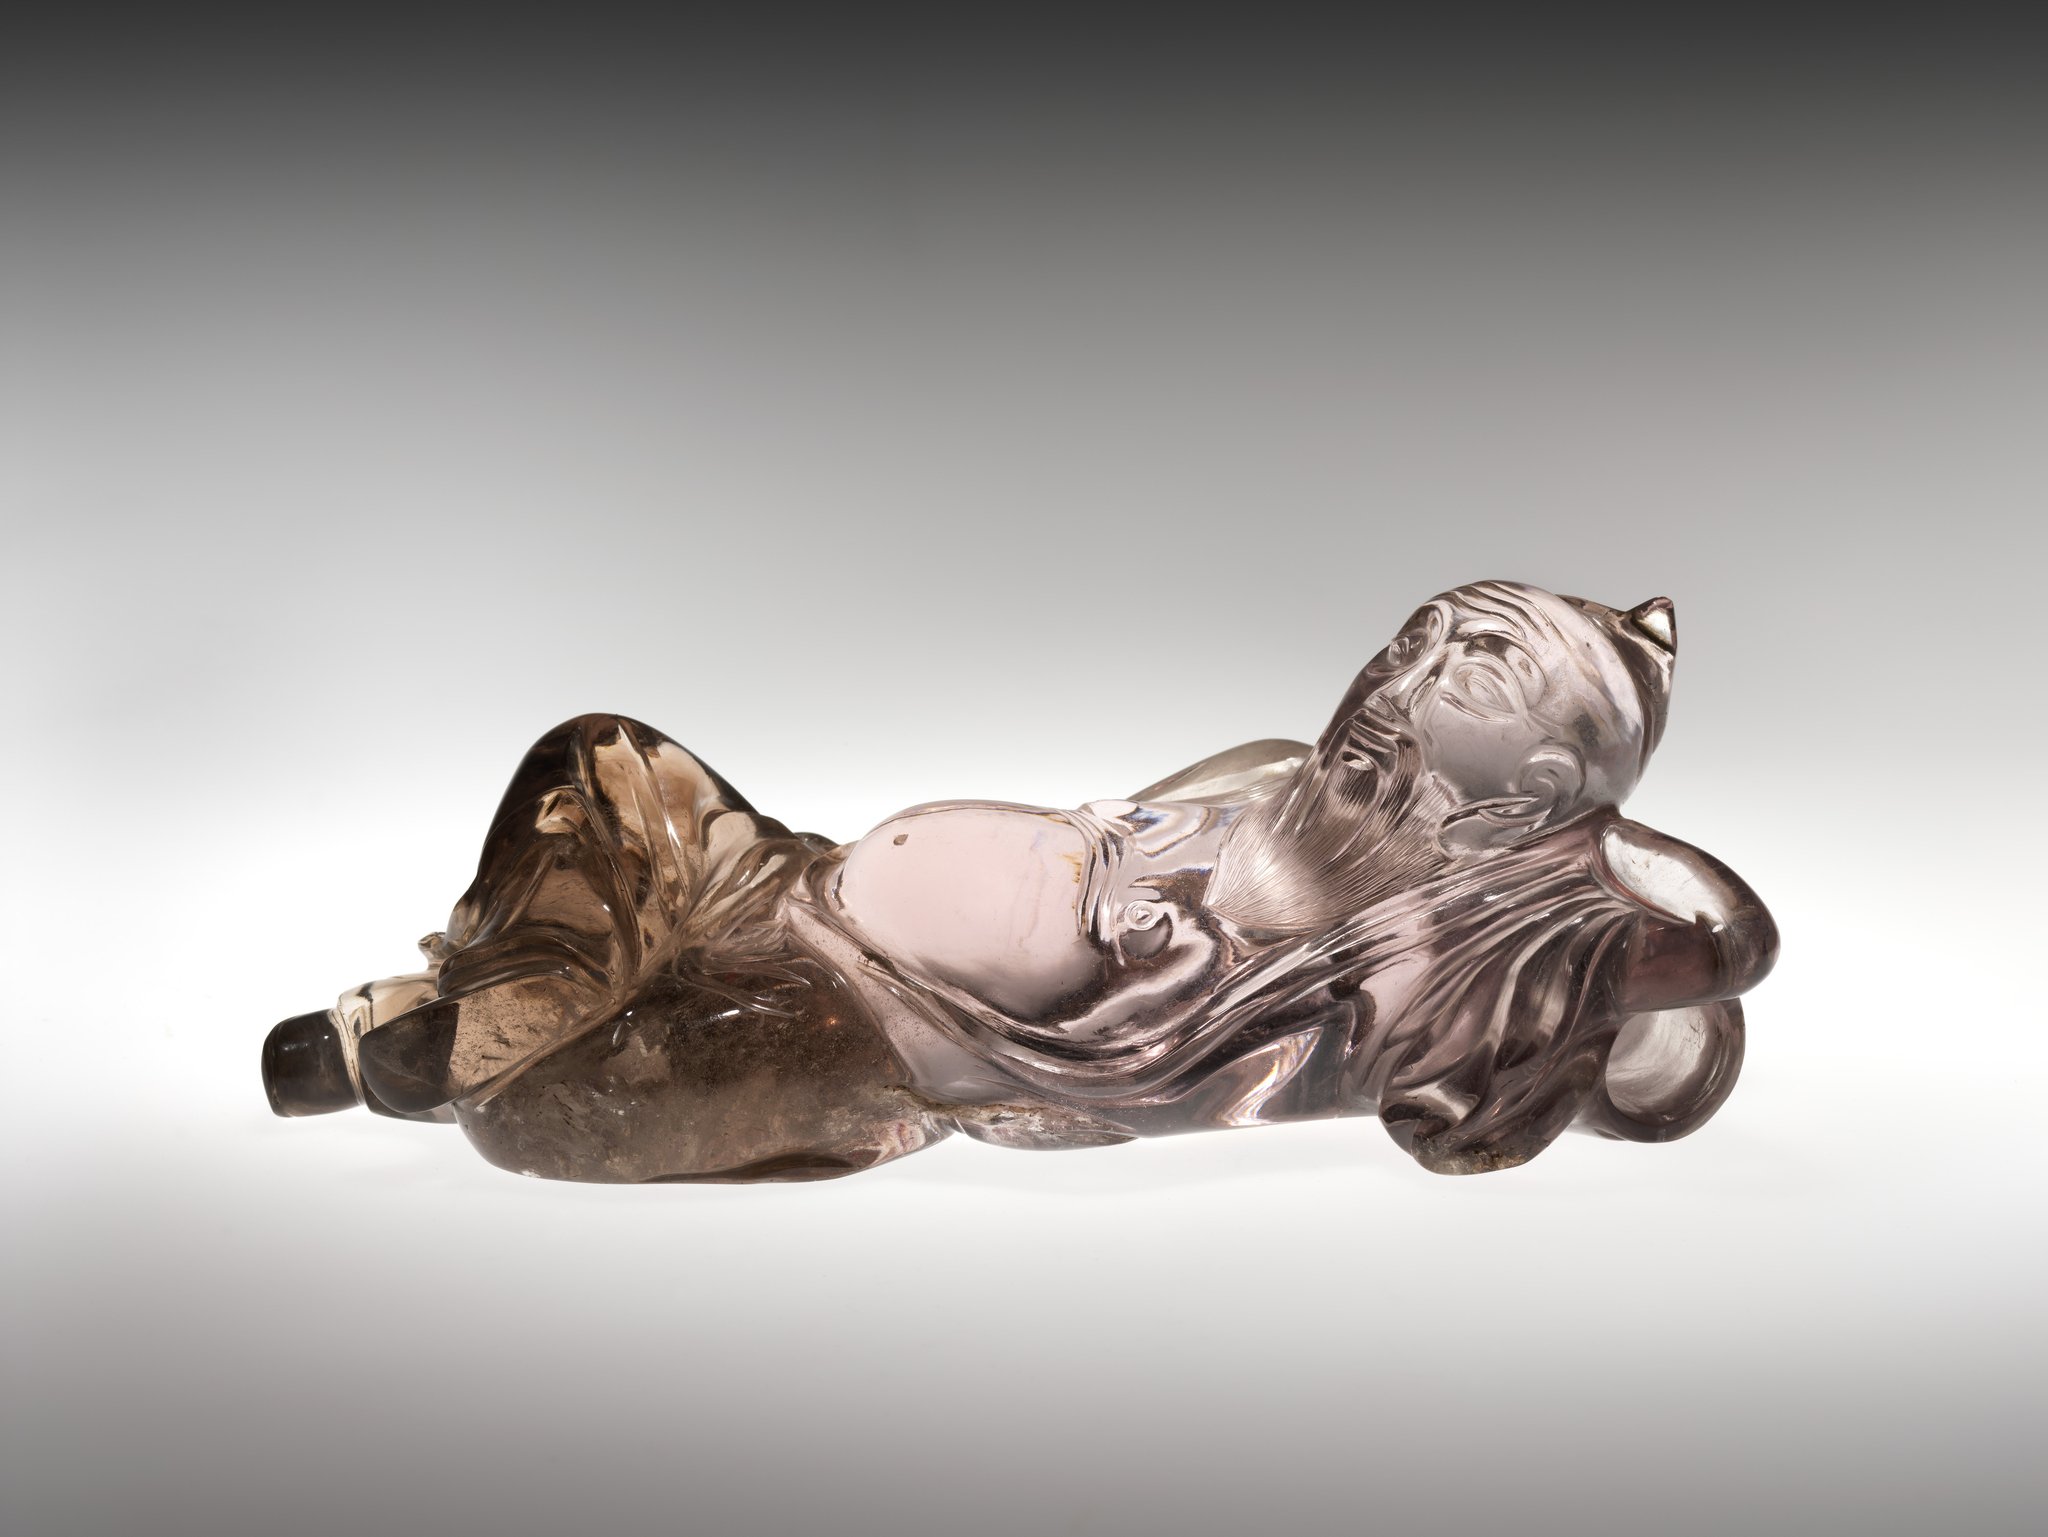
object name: figure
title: A drunken immortal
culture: chinese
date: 1701-1900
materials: quartz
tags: men,poets